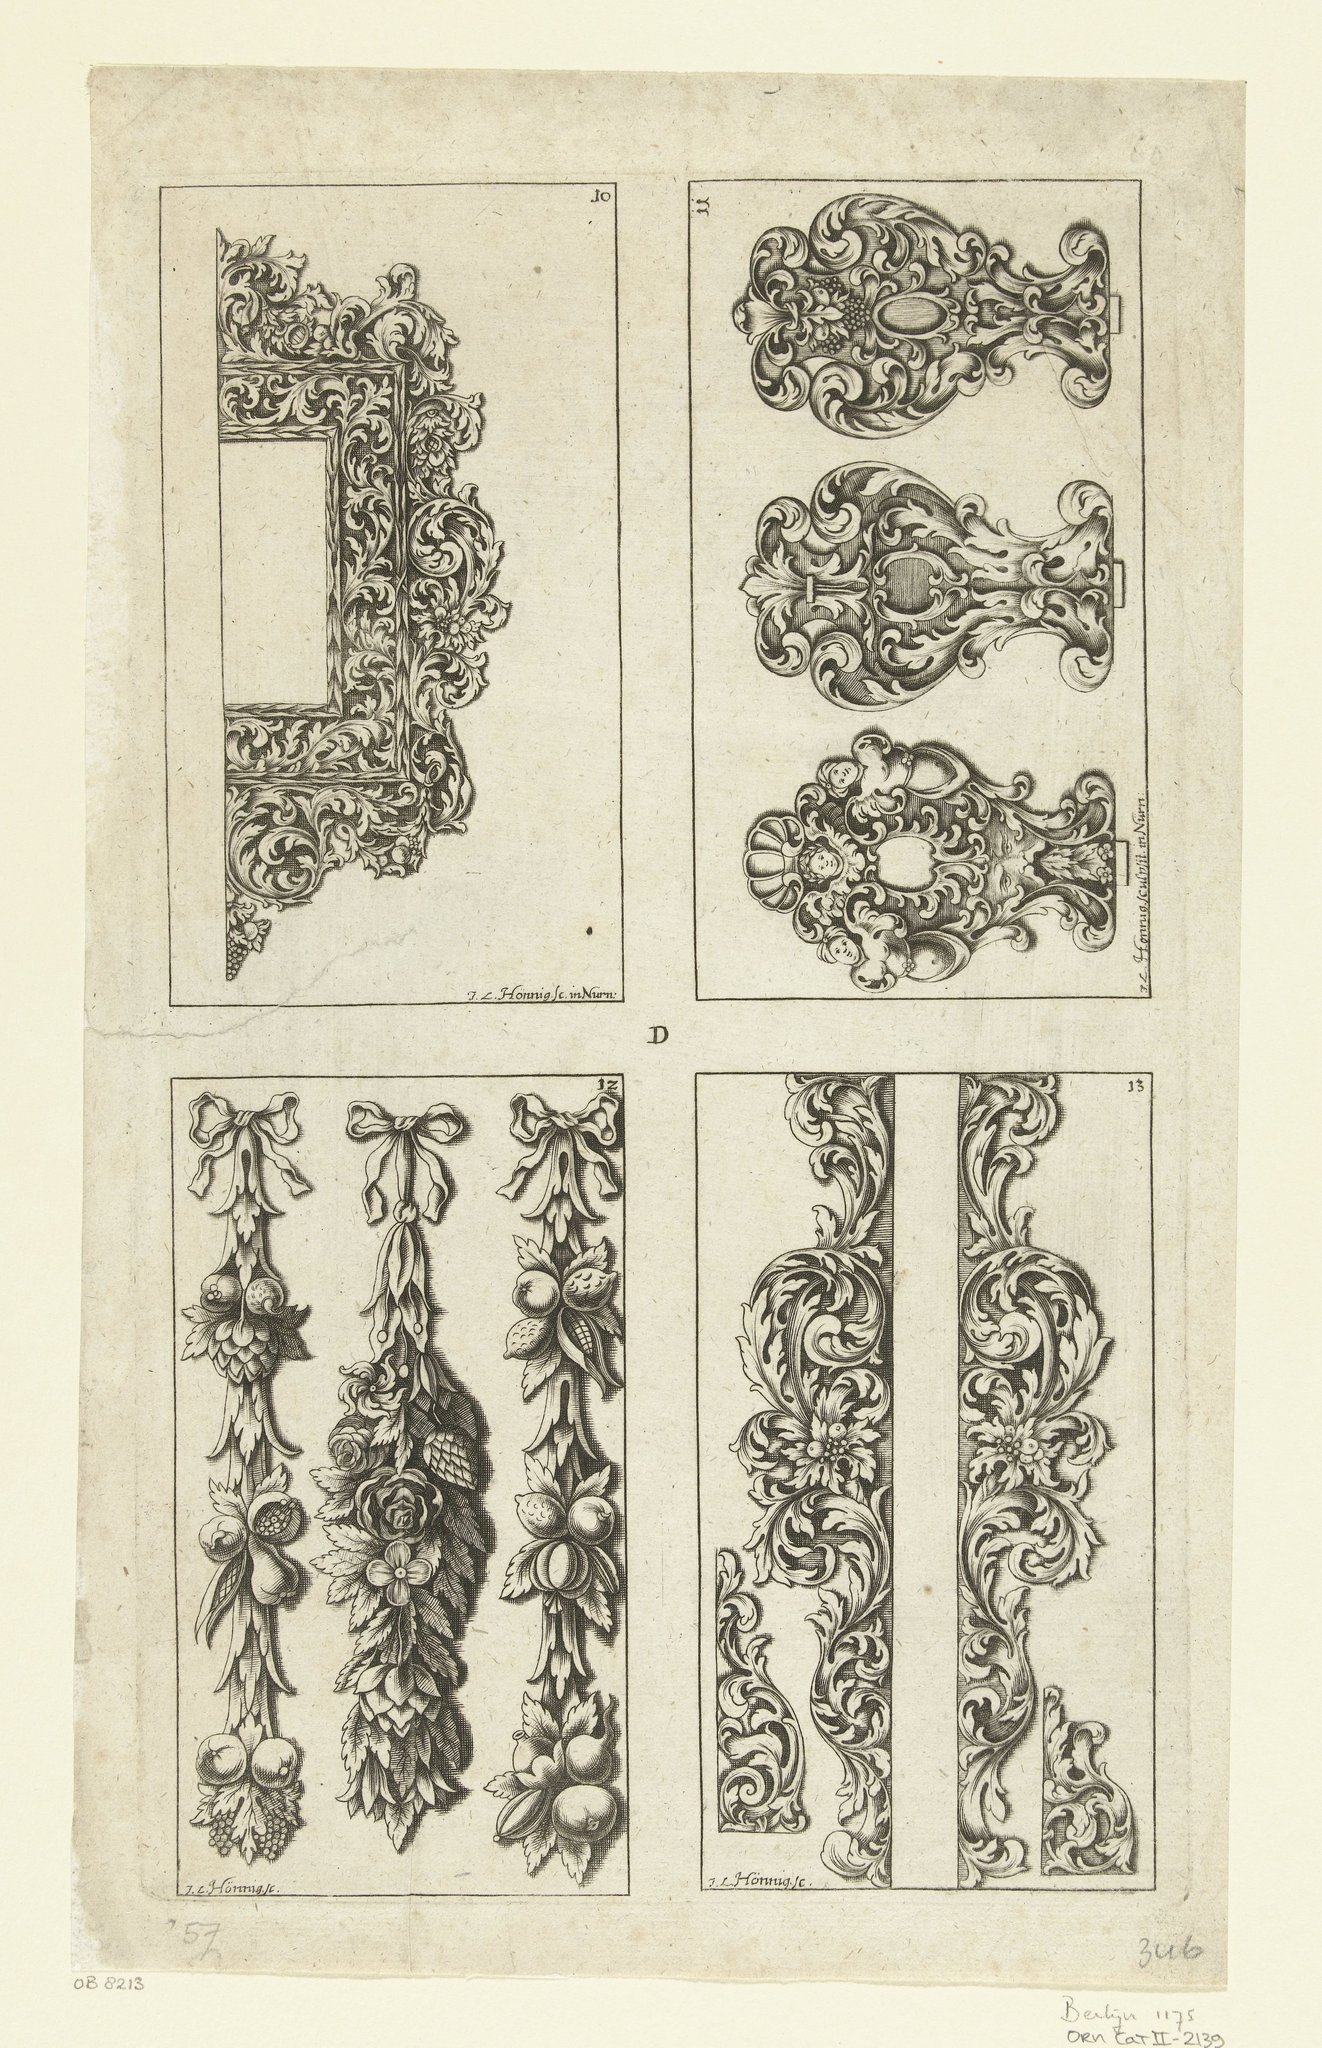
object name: ornament print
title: Elf meubeldecoraties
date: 1695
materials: paper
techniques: engraving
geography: nuremberg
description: Nummer 10 t/m 13. Nummer 10 laat de rechterhelft van een spiegellijst zien, op nummer 11 staan drie achterkanten van stoelen, op nummer 12 drie festoenen met fruit en bloemen en op nummer 13 staan twee hoekstijlen en twee kleinere ornamentele delen van lijsten.